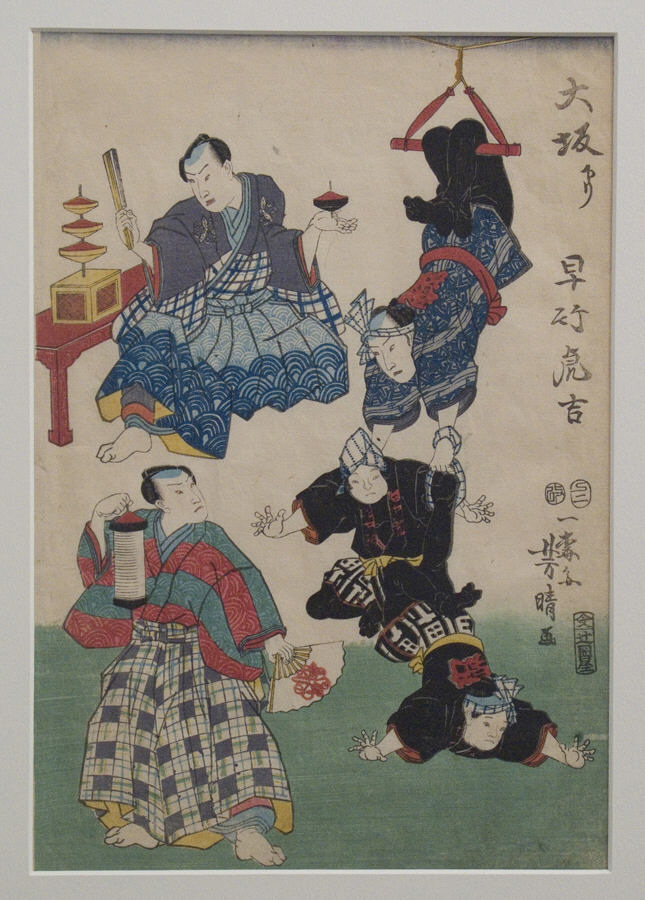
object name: print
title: Hayatake Torakichi from Osaka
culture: japanese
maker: utagawa yoshiharu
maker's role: artist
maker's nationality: japanese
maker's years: 1828-1888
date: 1857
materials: ink, paper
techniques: woodblock print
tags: performance,fans,men,acrobats